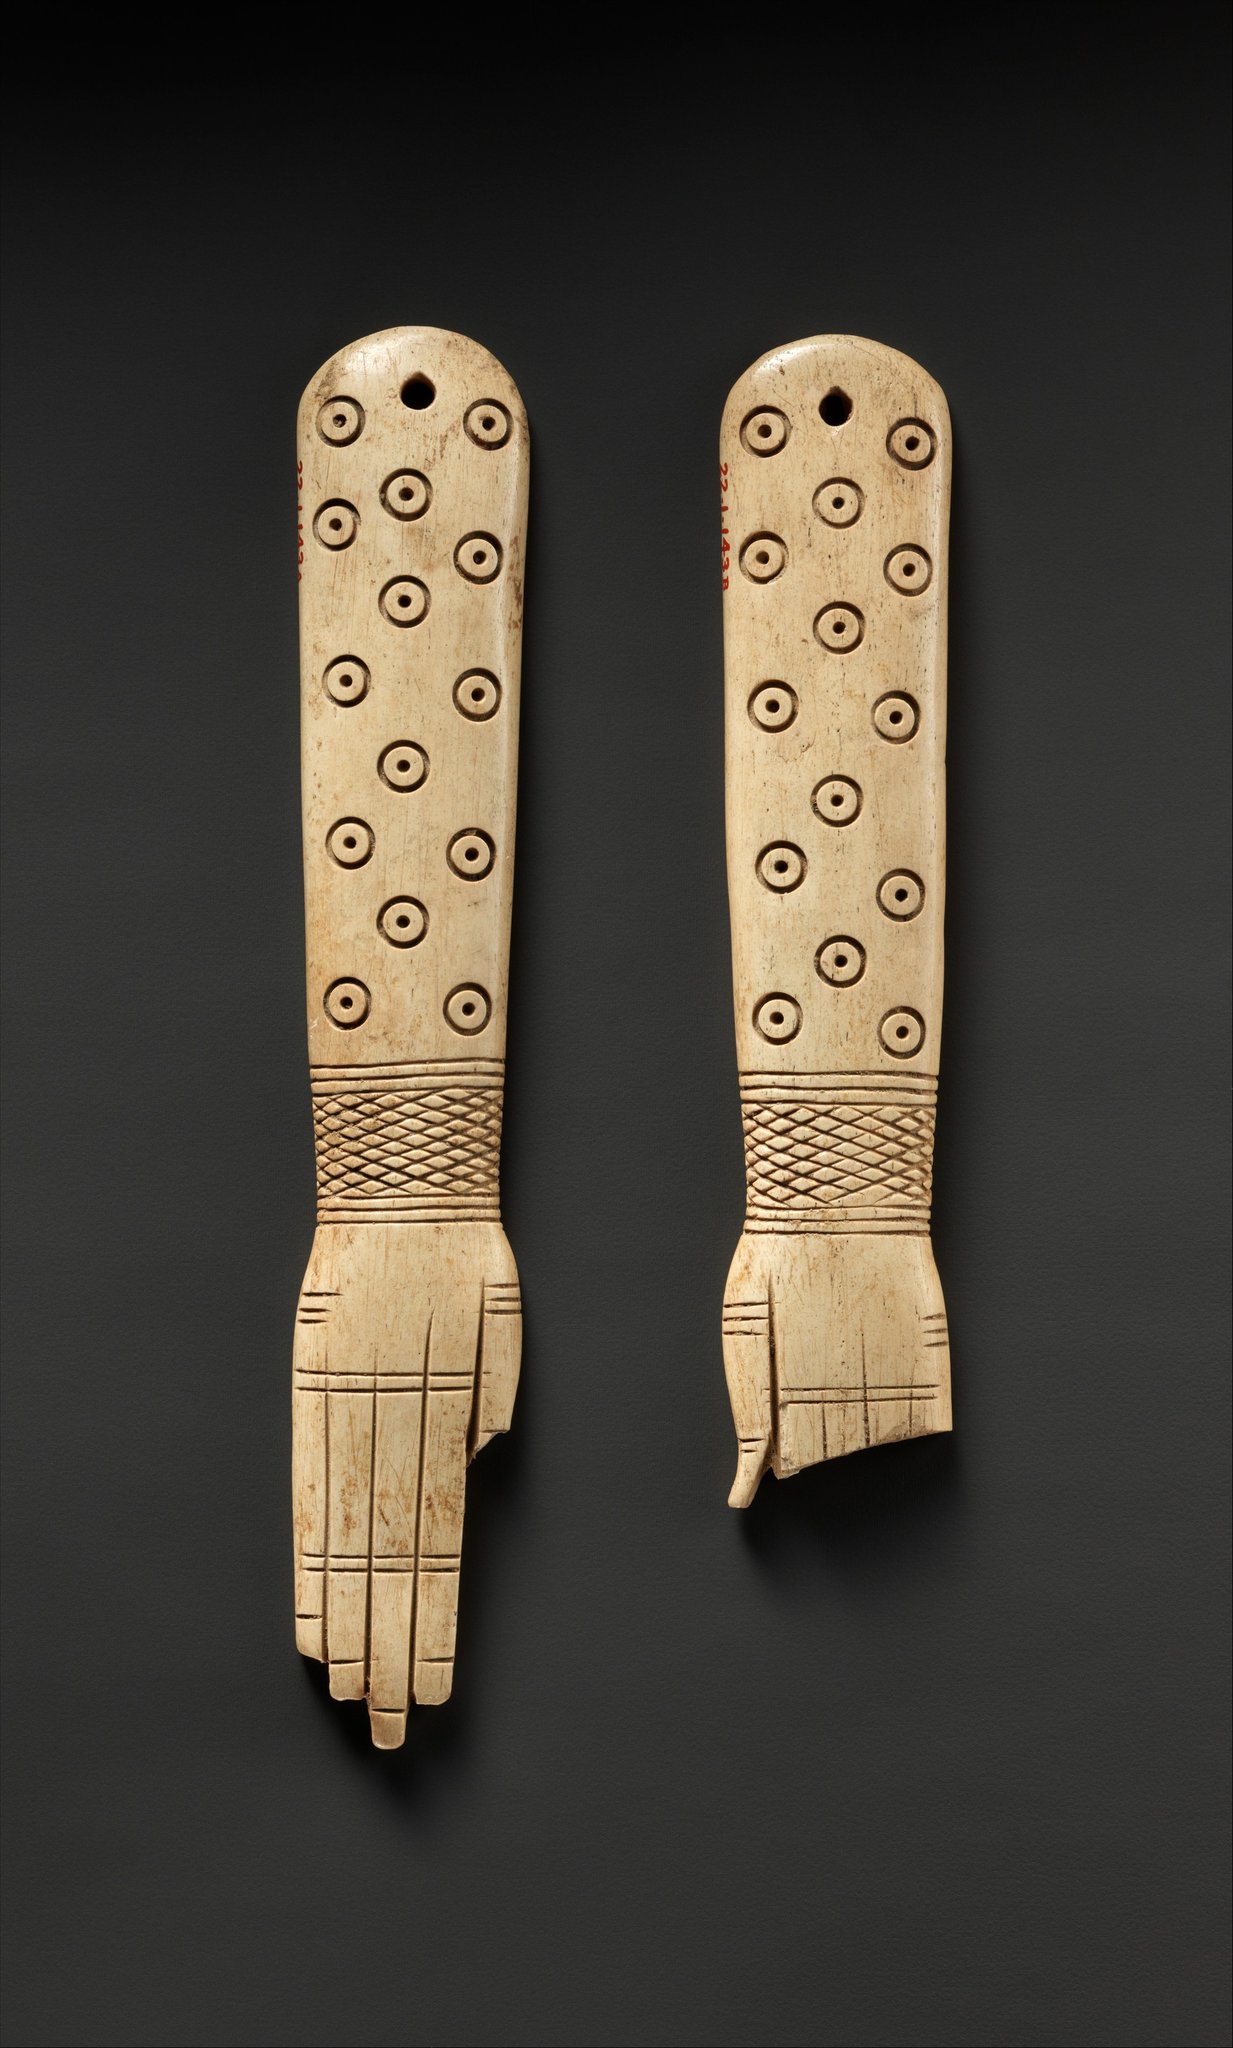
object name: music, clapper, arm, hand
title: Pair of clappers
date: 1900-1640 BCE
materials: ivory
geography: egypt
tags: musical instruments,hands